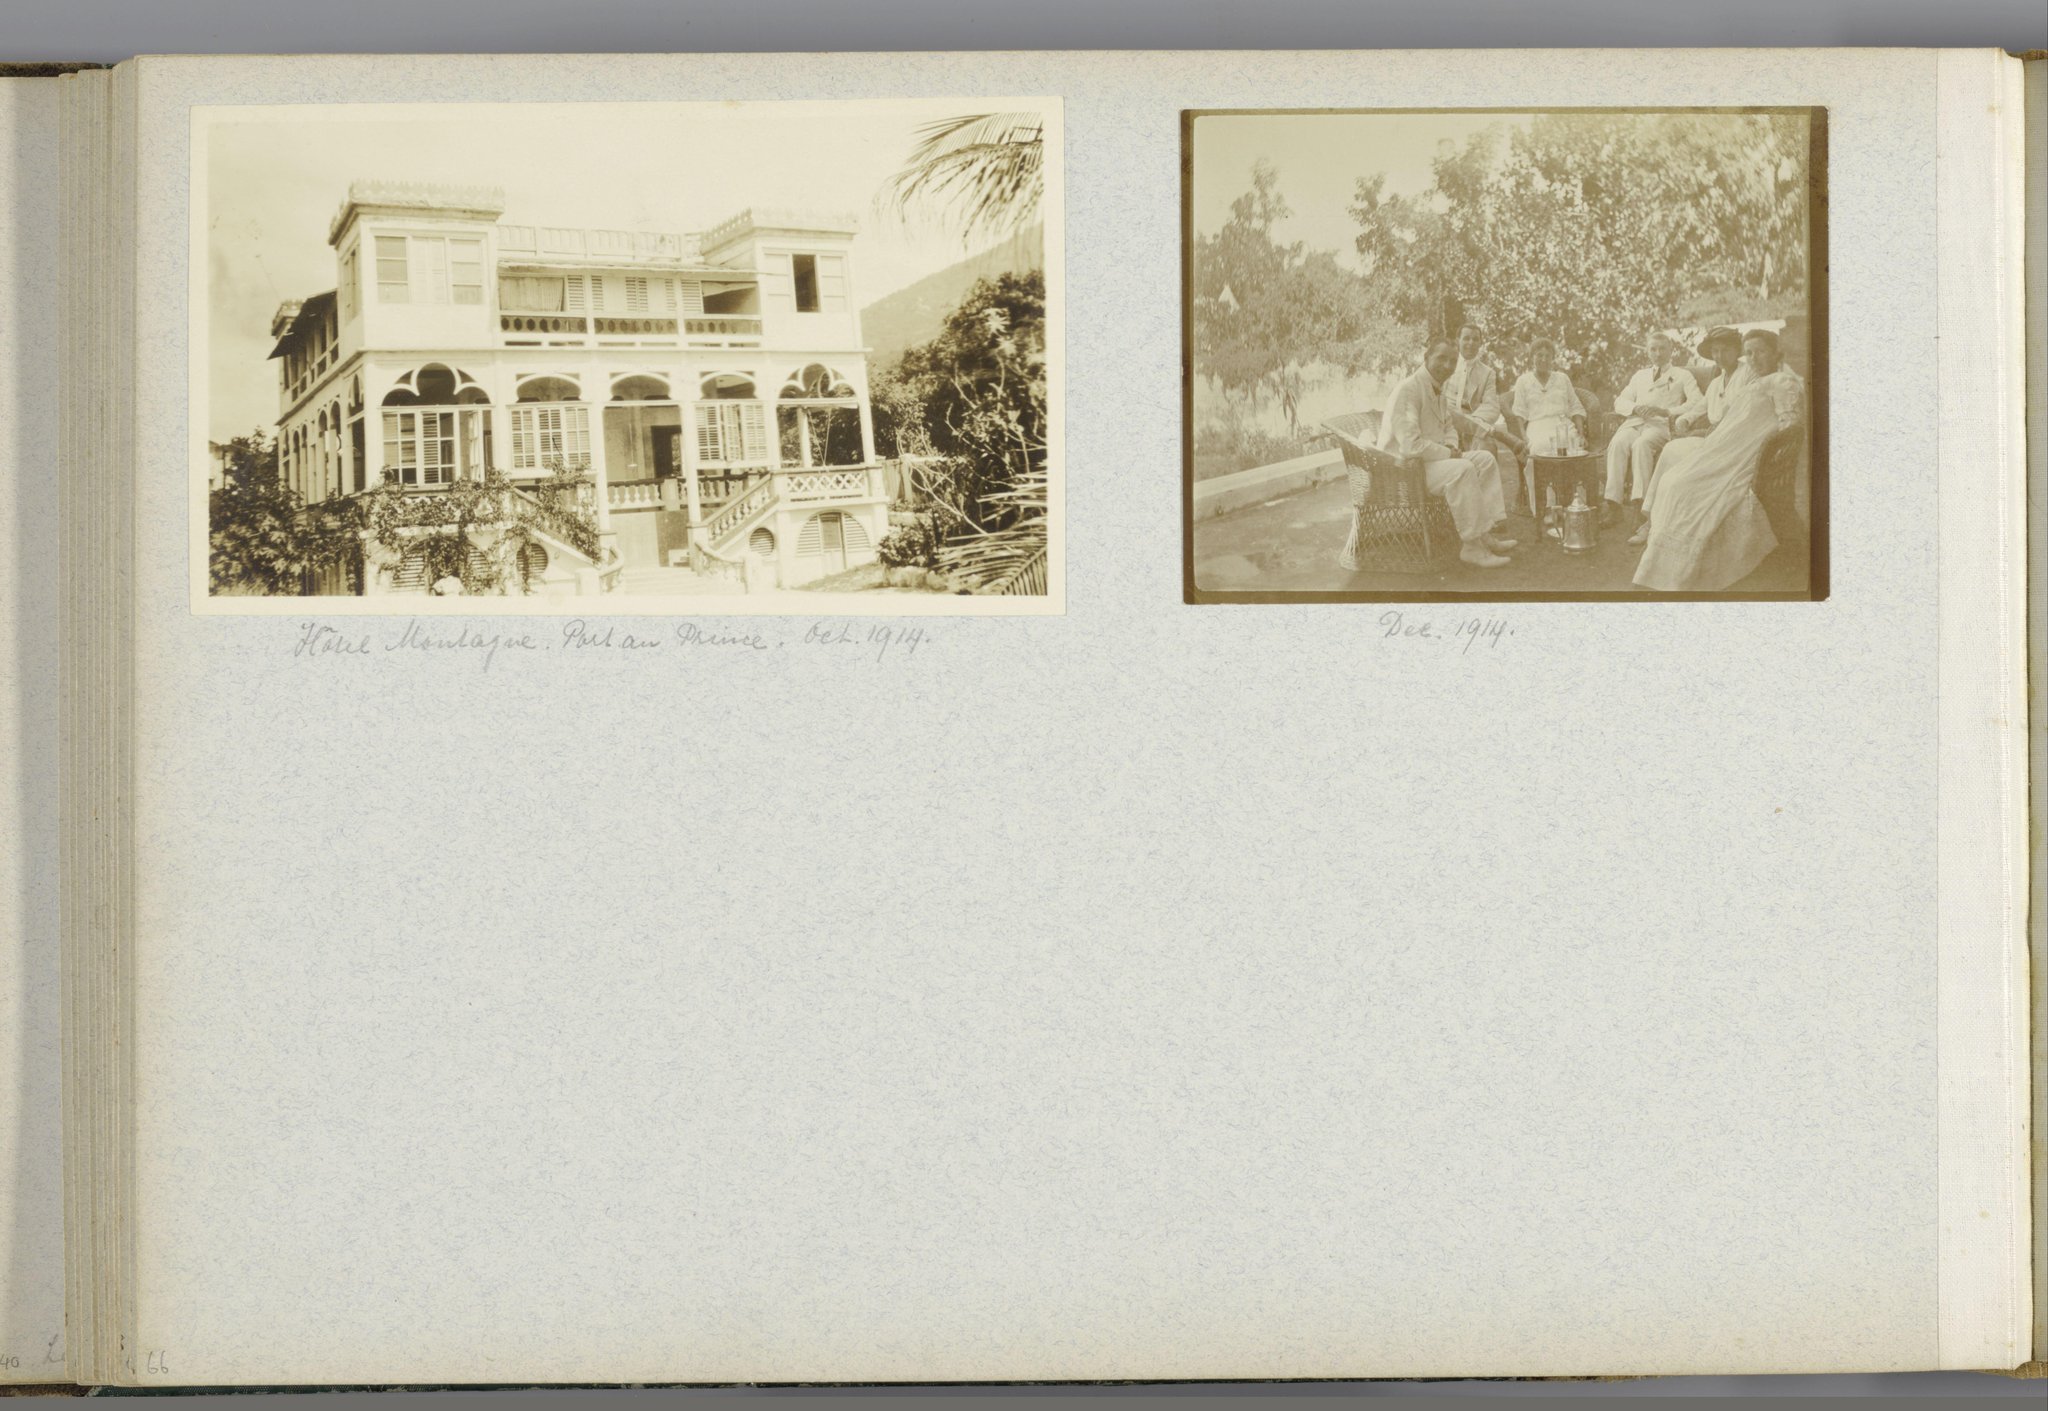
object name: photograph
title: Albumblad met twee foto's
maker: andries augustus boom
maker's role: amateurfotograaf, handelaar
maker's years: 1878-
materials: paper, photographic support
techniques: photography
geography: port-au-prince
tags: amsterdam, andries augustus boom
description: Albumblad met twee foto's, waarvan één in Port-au-Prince, oktober en december 1914. Onderdeel van het fotoalbum van de familie Boom-Gonggrijp in Suriname en Curaçao.